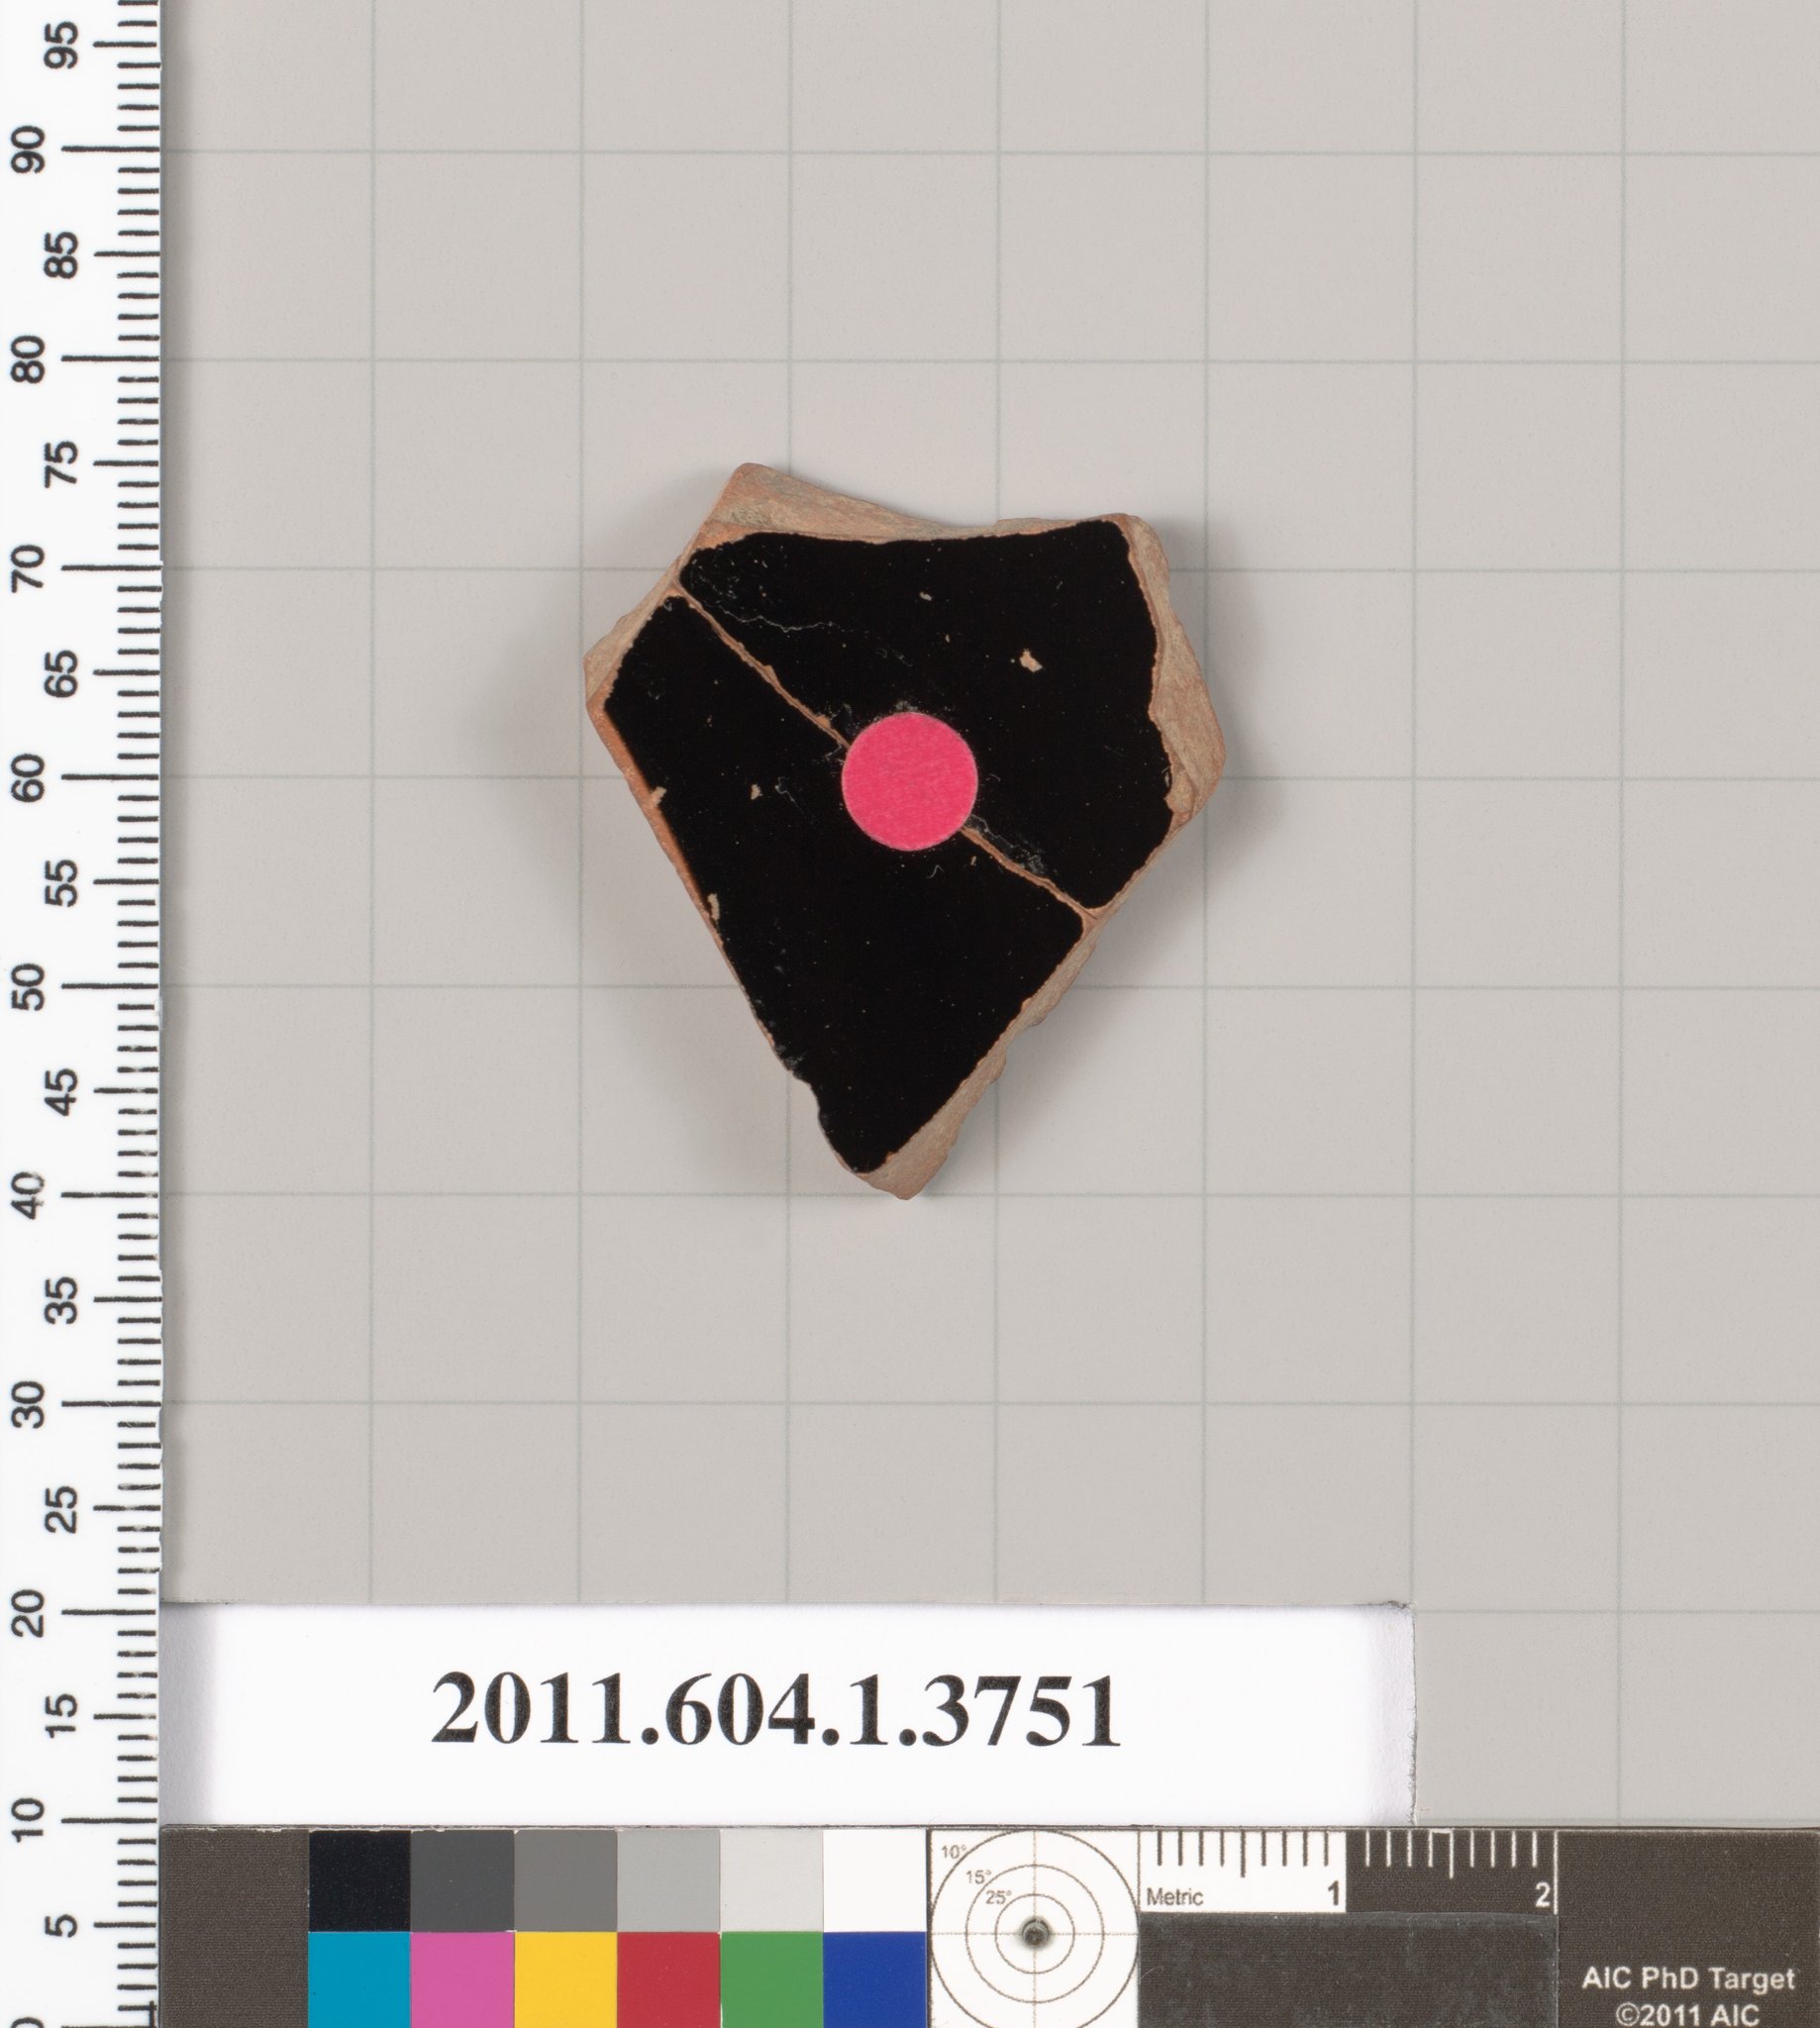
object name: kylix fragment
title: Terracotta fragment of a kylix (drinking cup)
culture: greek, attic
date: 490-470 BCE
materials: terracotta